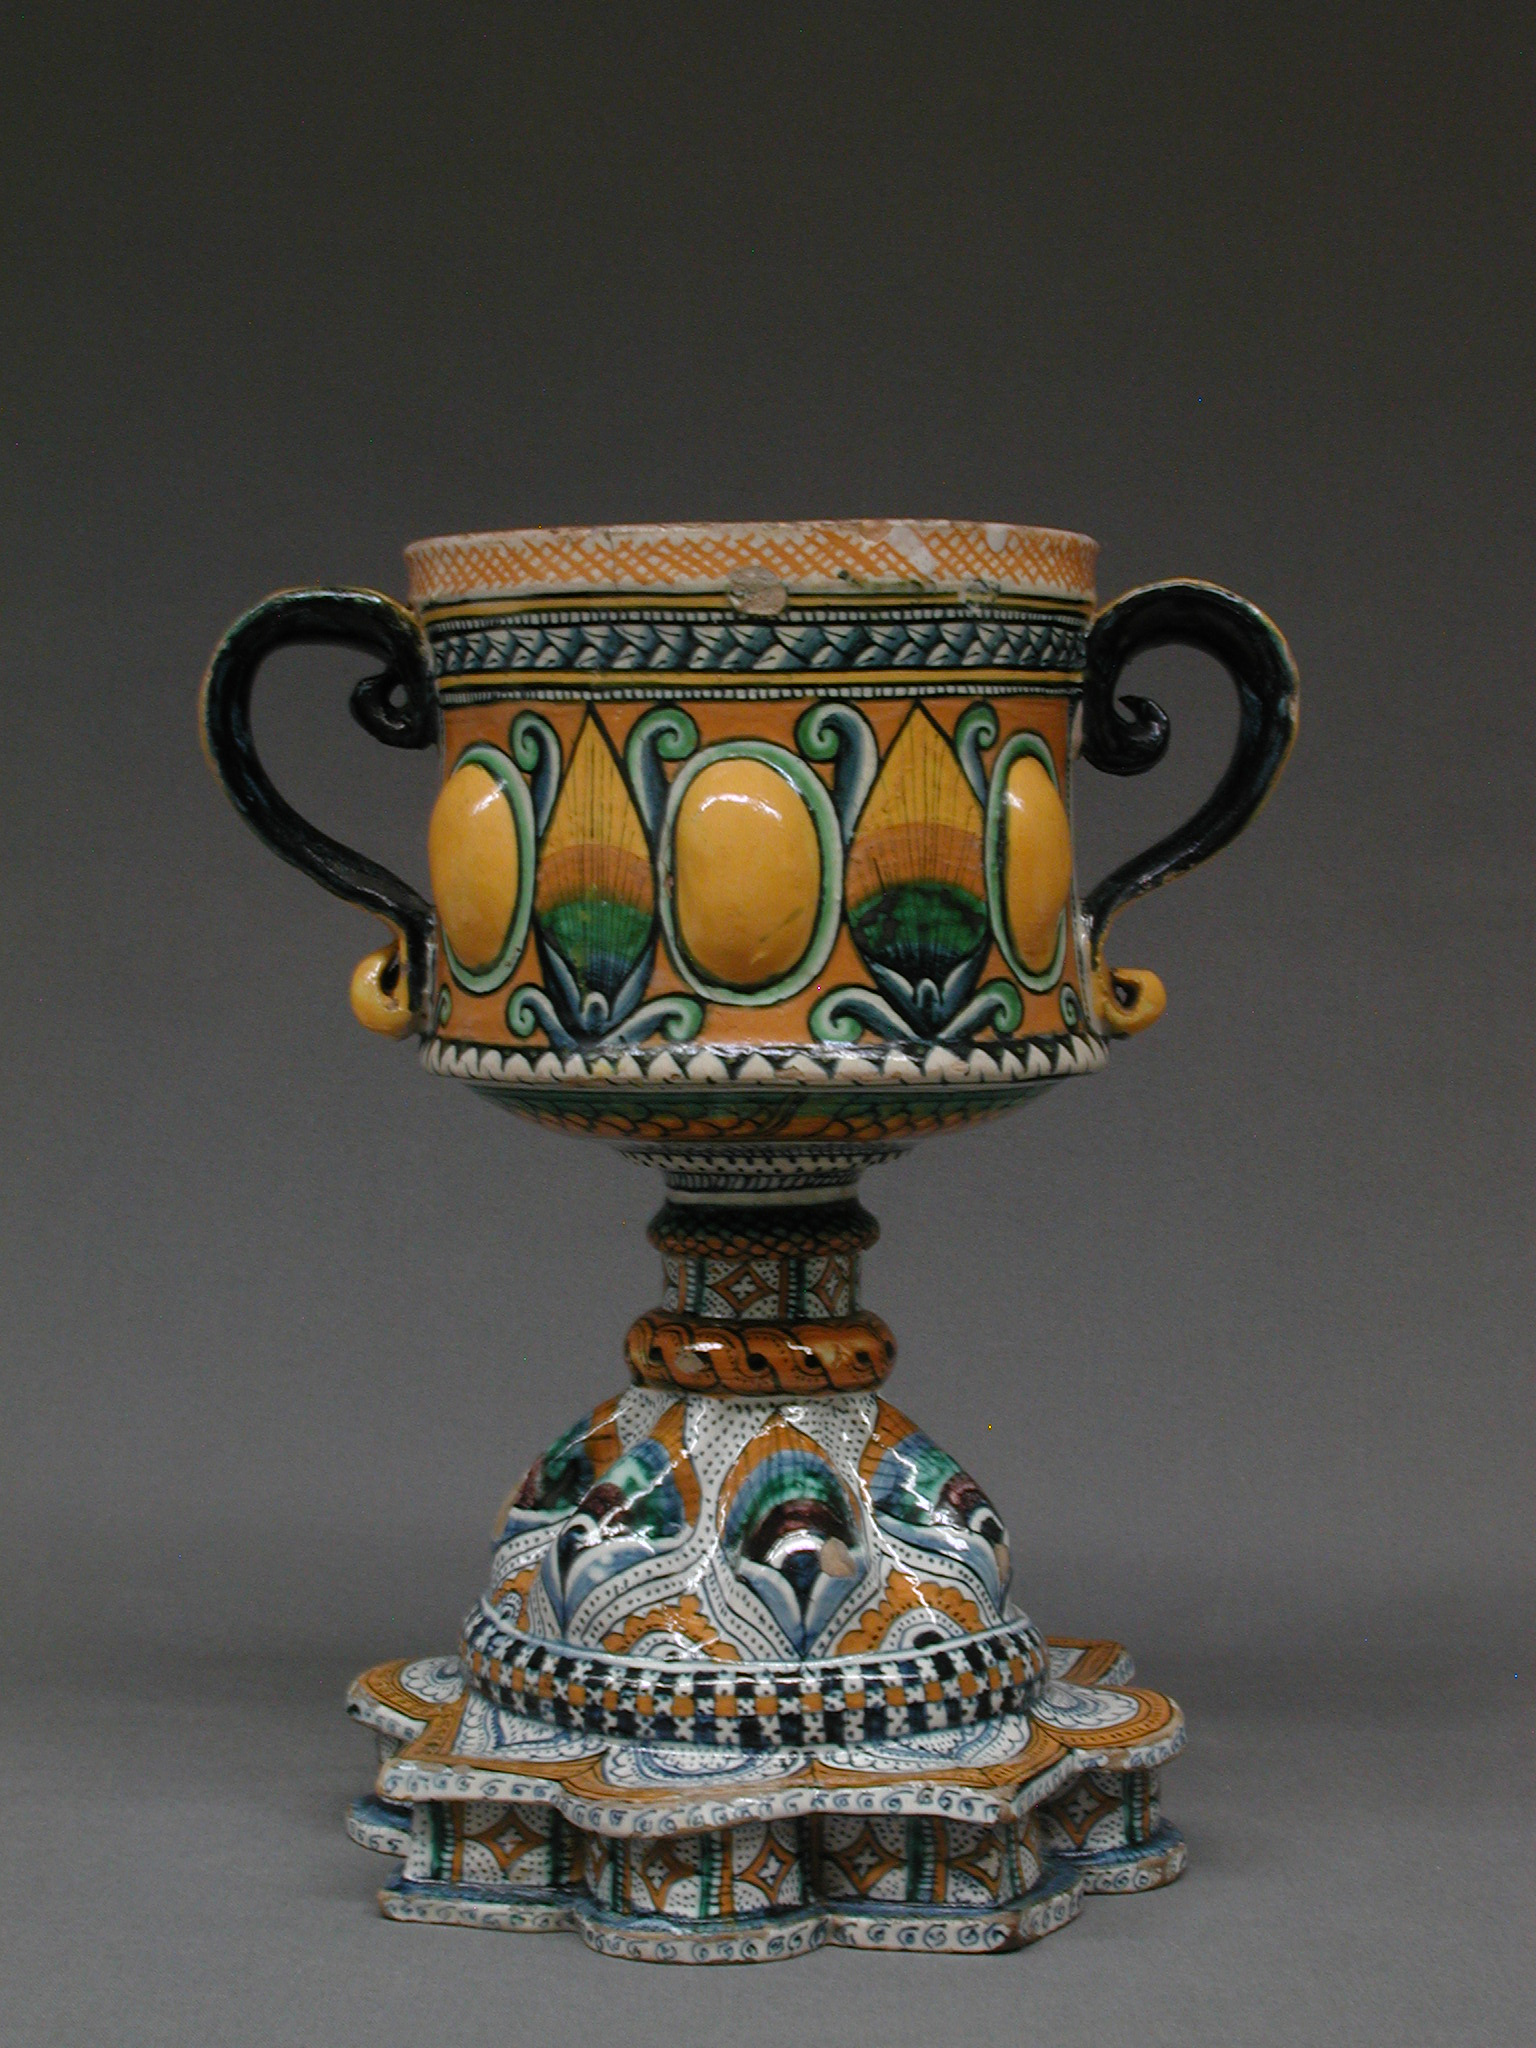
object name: standing cup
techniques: maiolica, glazing